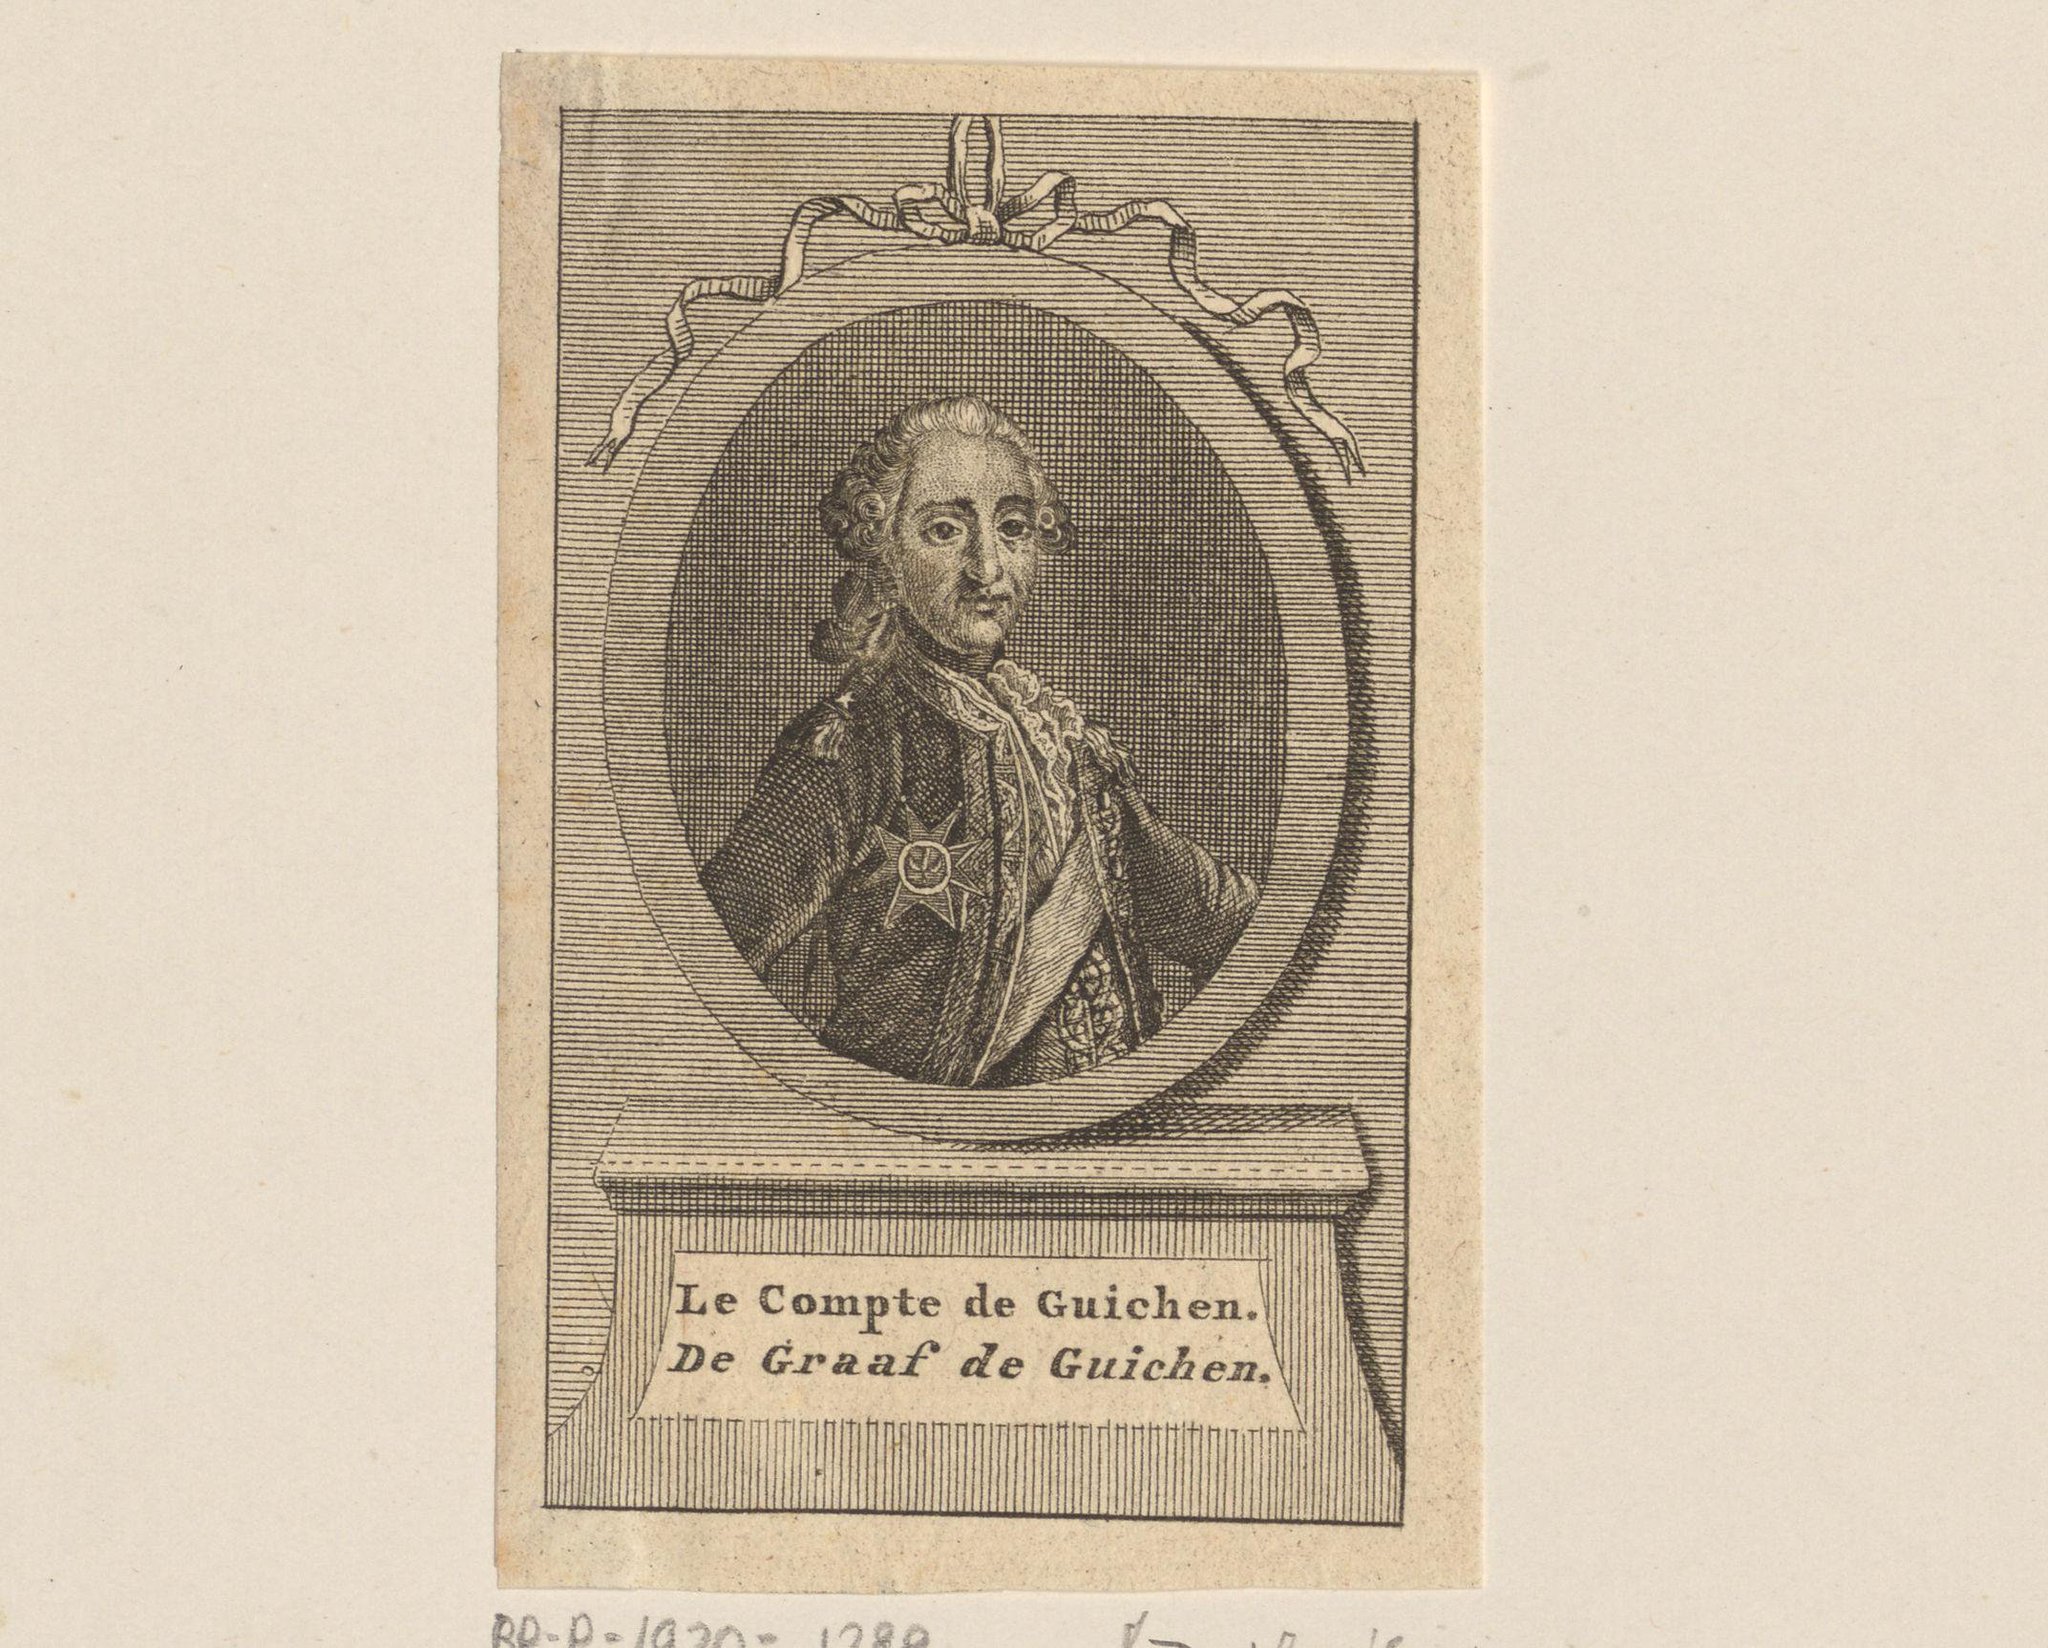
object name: print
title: Portret van Luc Urbain du Bouëxic, graaf van Guichen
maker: Anonymous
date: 1722-1822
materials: paper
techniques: engraving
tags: naval officer, historical persons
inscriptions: collector's mark: Lugt 2228